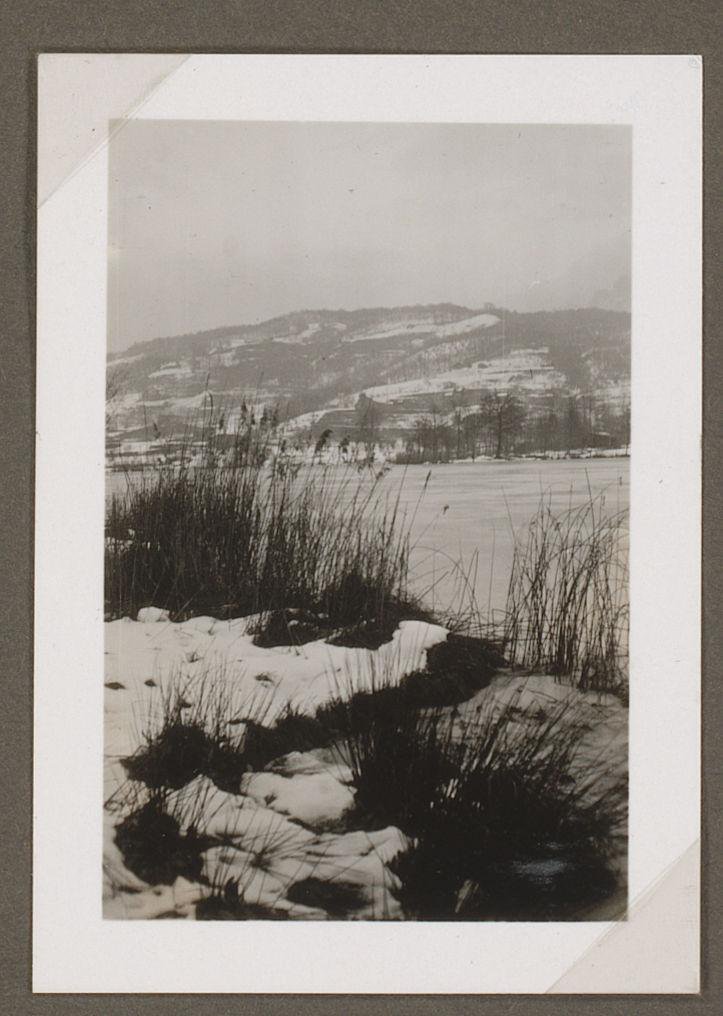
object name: photograph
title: Meer van Origlio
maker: Anonymous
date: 1933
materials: photographic support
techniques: gelatin silver print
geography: origlio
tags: lake, snow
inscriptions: number: ‘29’